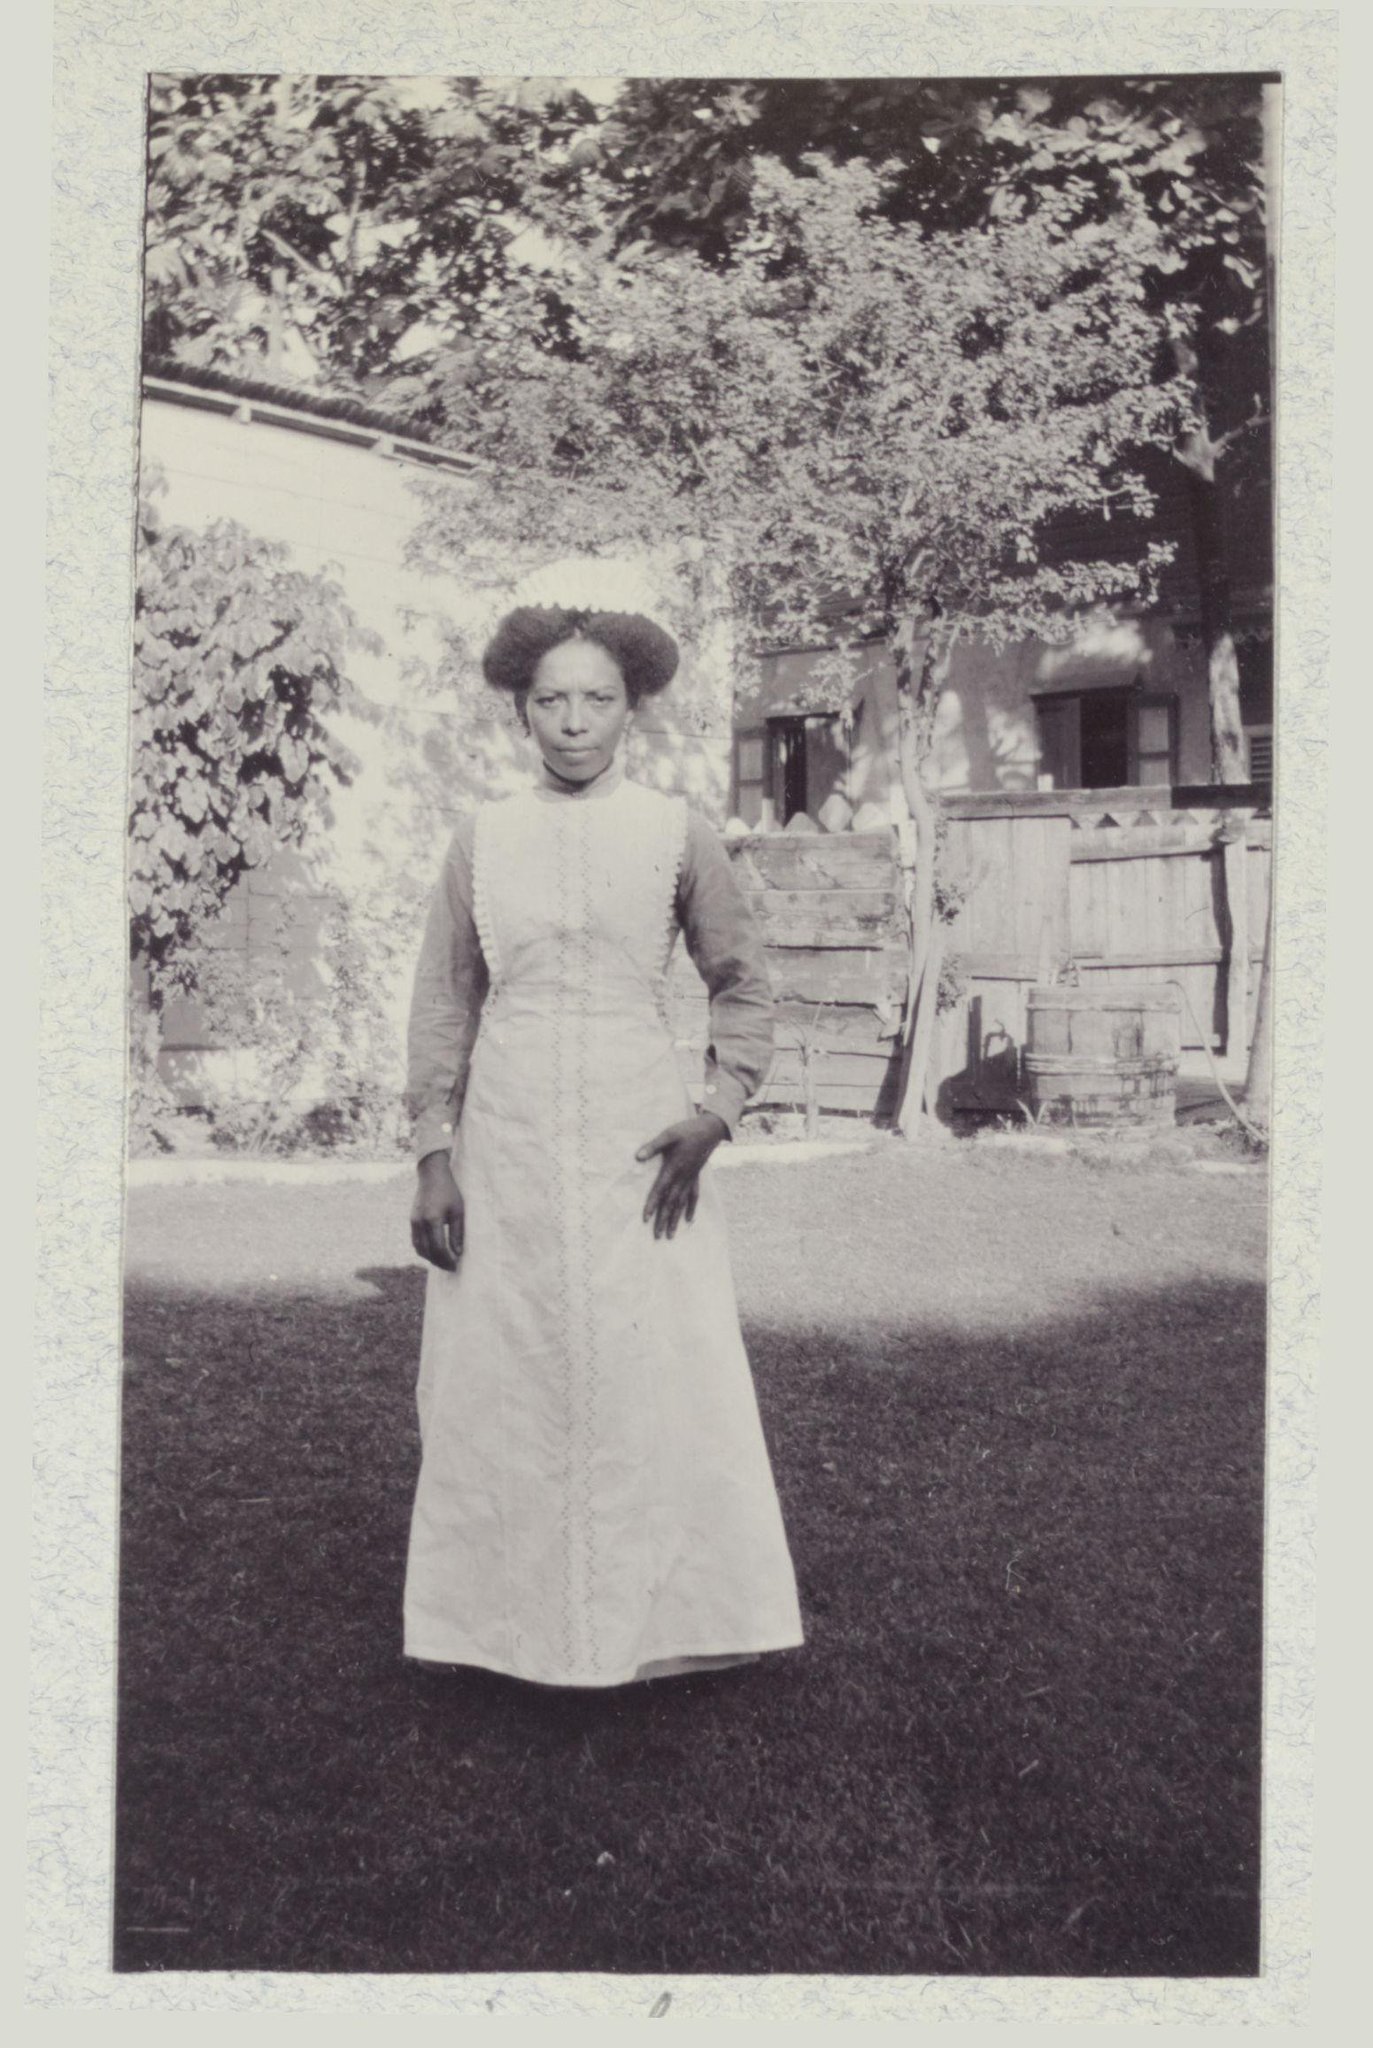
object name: photograph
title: Kamermeisje Beatrix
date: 1901-1912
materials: photographic support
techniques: photography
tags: maid ~ house personnel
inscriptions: inscription: ‘Beatrix. kamermeisje St. Marc 1912’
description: Portret van het kamermeisje genaamd Beatrix, staande in de tuin van het huis van Mr. en Mrs. Hall in Port-au-Prince op Haïti, januari 1912. Onderdeel van het fotoalbum van de familie Boom-Gonggrijp in Suriname en Curaçao.